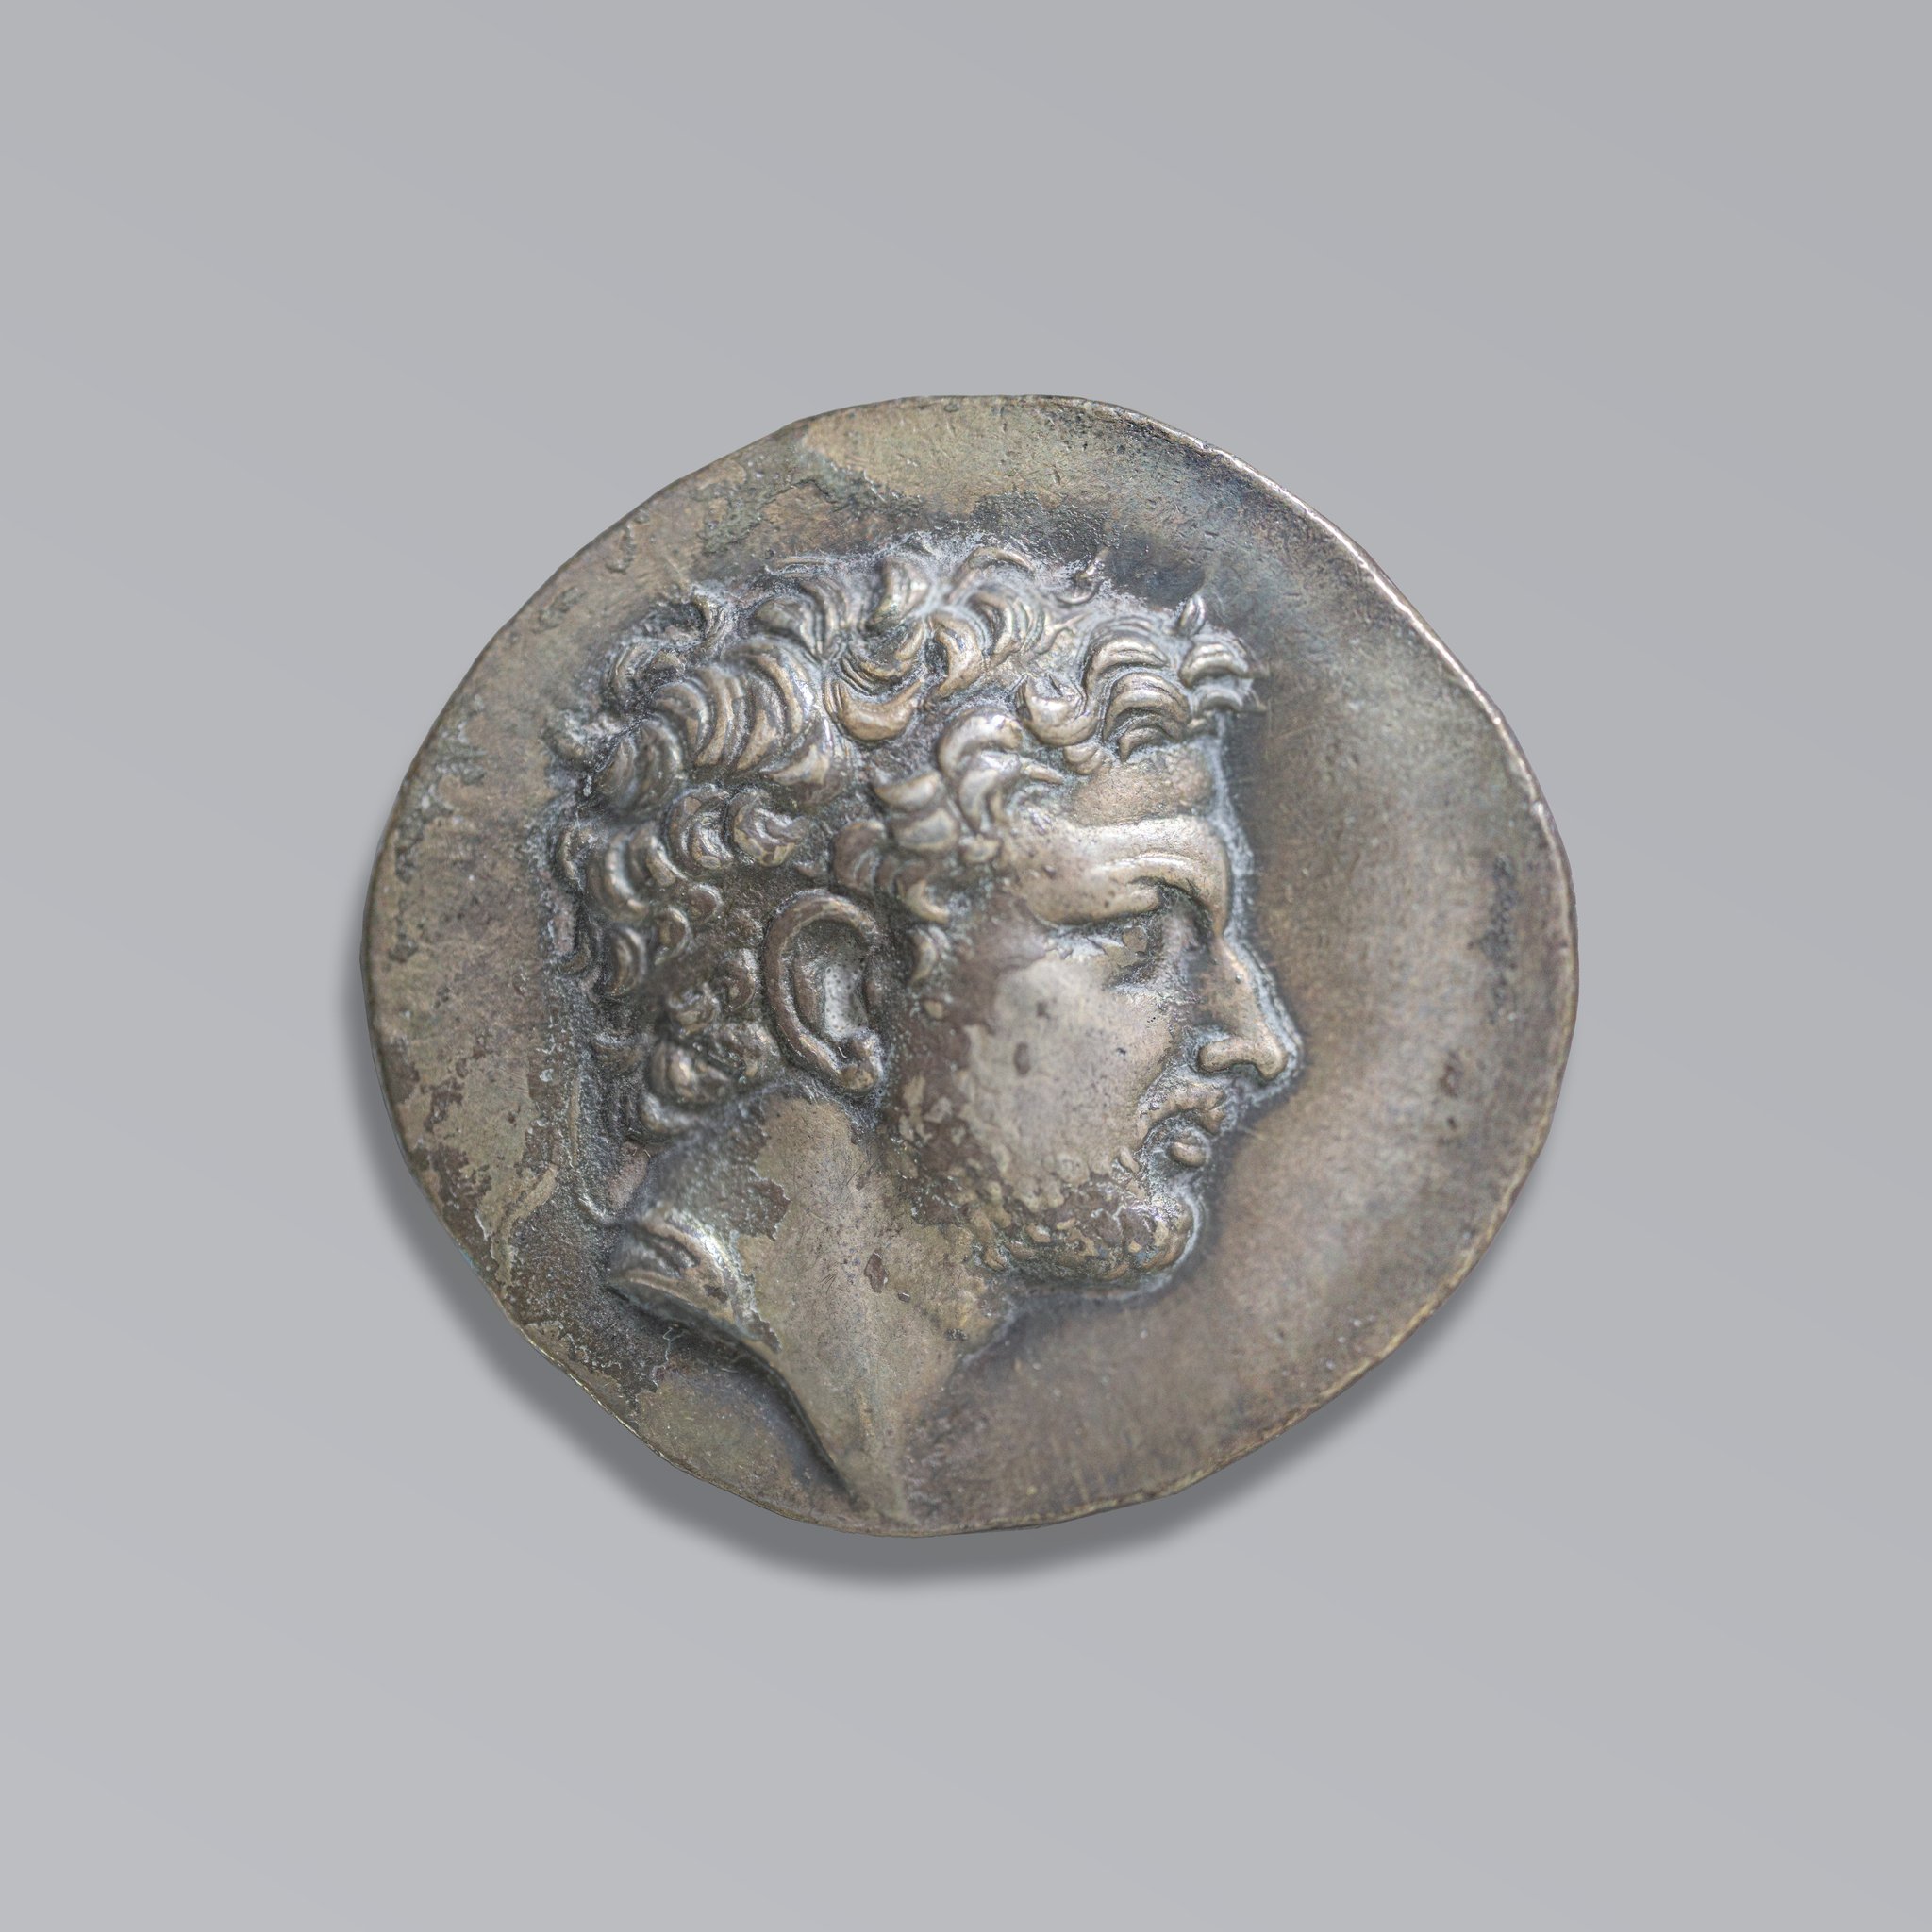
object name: tetradrachm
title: Silver tetradrachm of Perseus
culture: greek, macedonian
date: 178-168 BCE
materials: silver